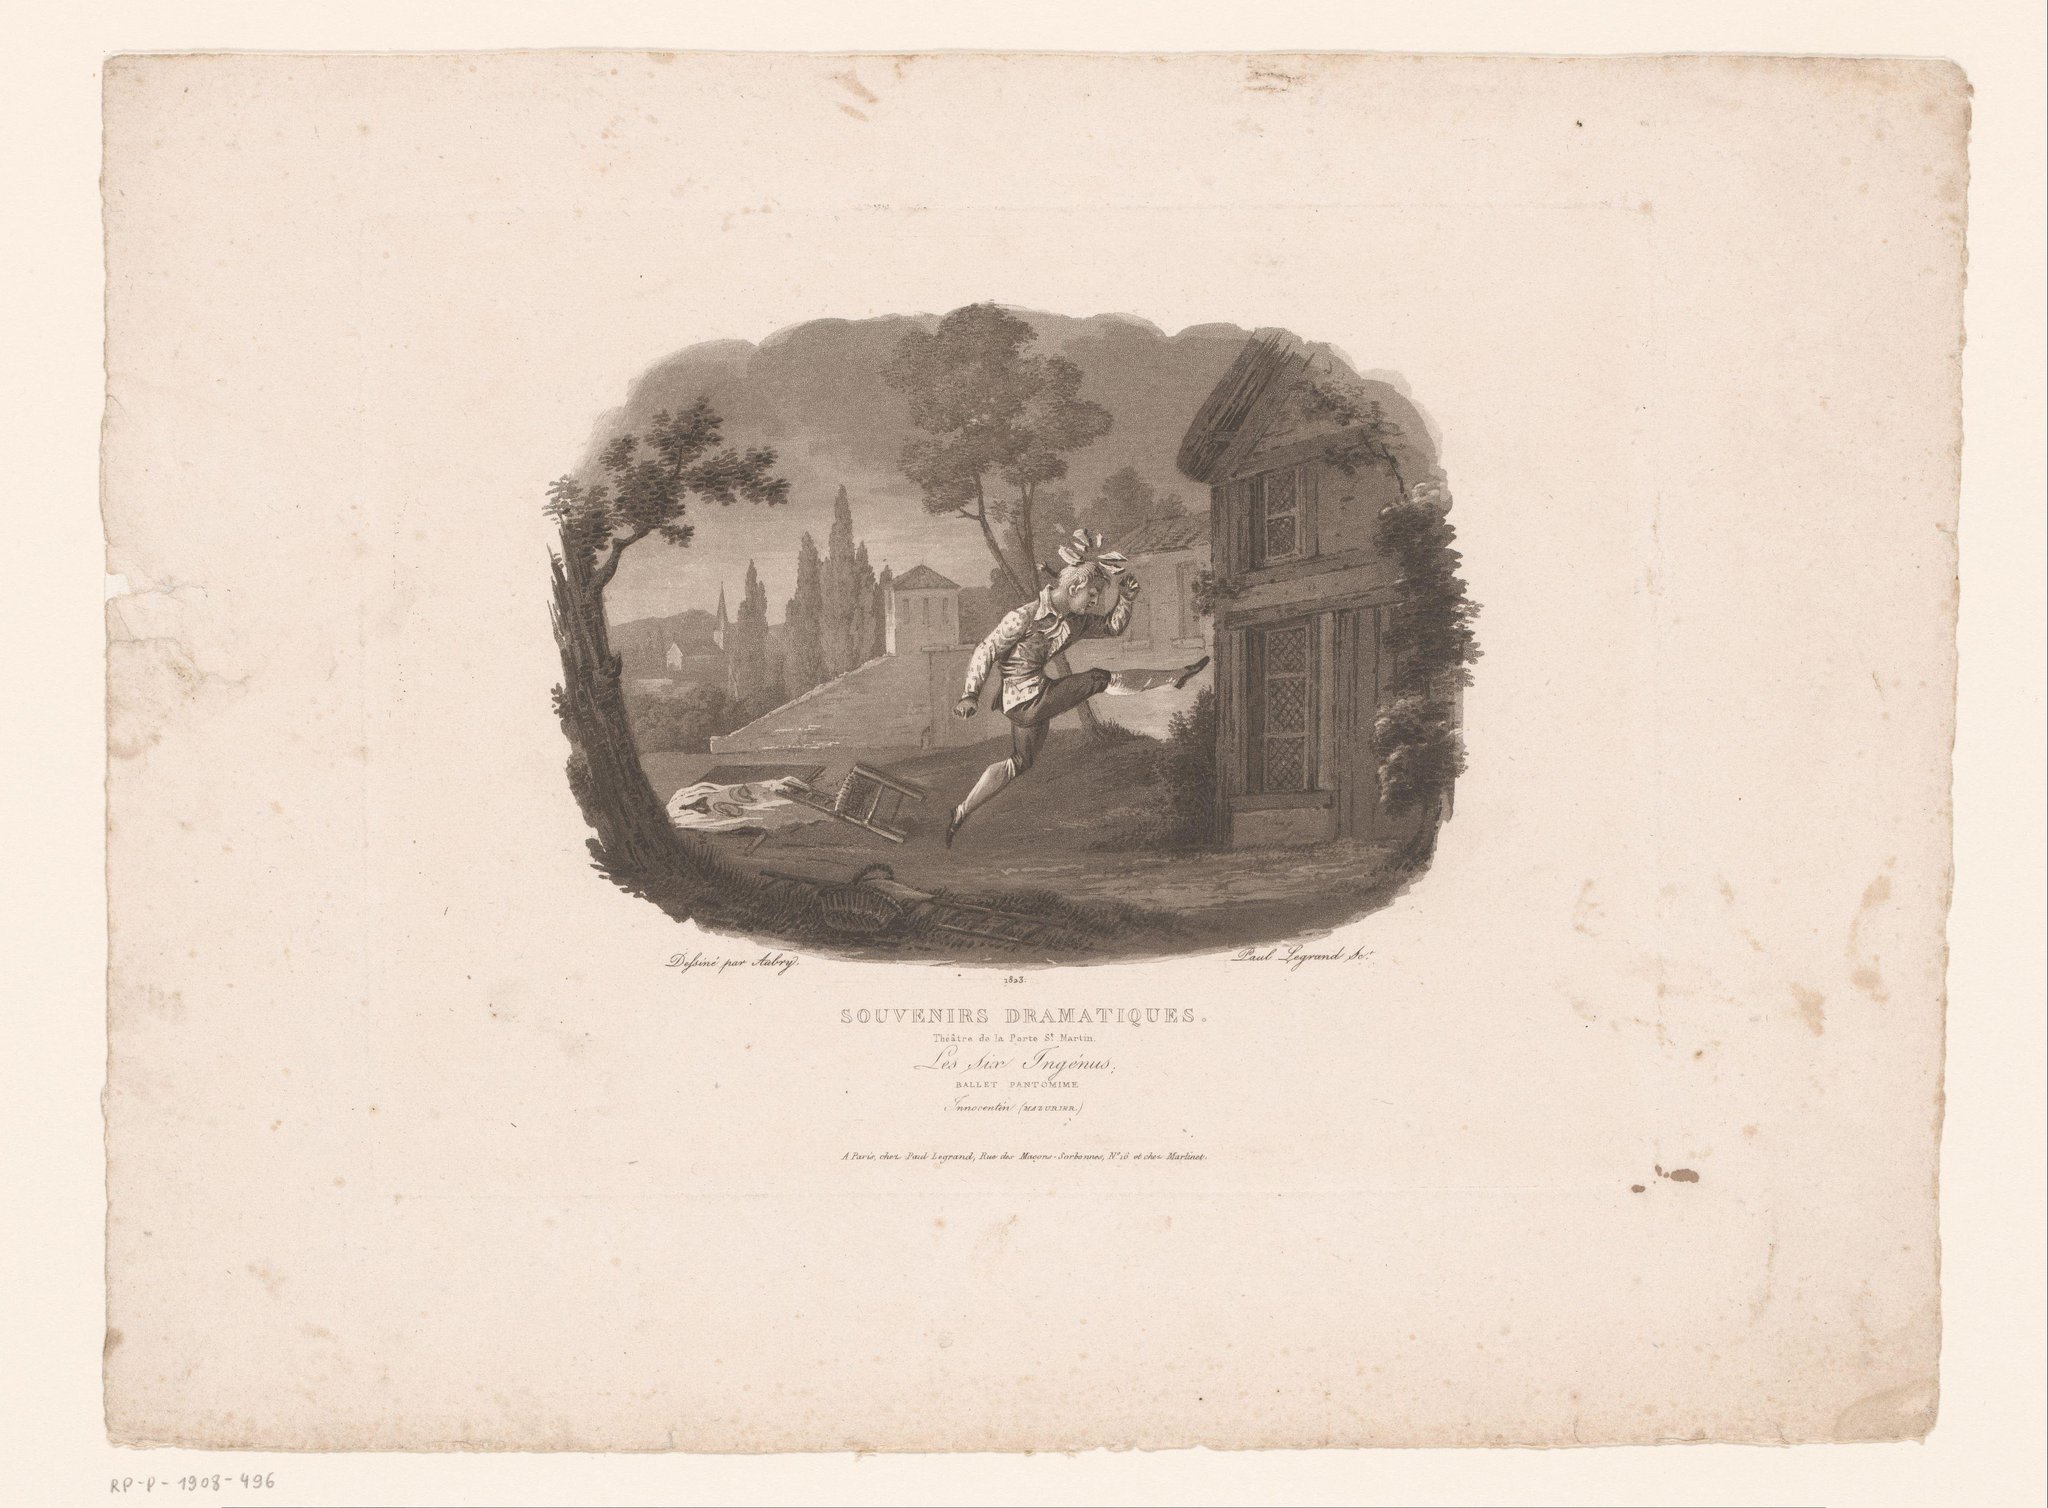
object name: print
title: Les Six Ingénus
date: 1823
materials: paper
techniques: aquatint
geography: paris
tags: jumping up, youth, adolescent, pantomime, dumb show, masque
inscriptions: collector's mark: Lugt 2228